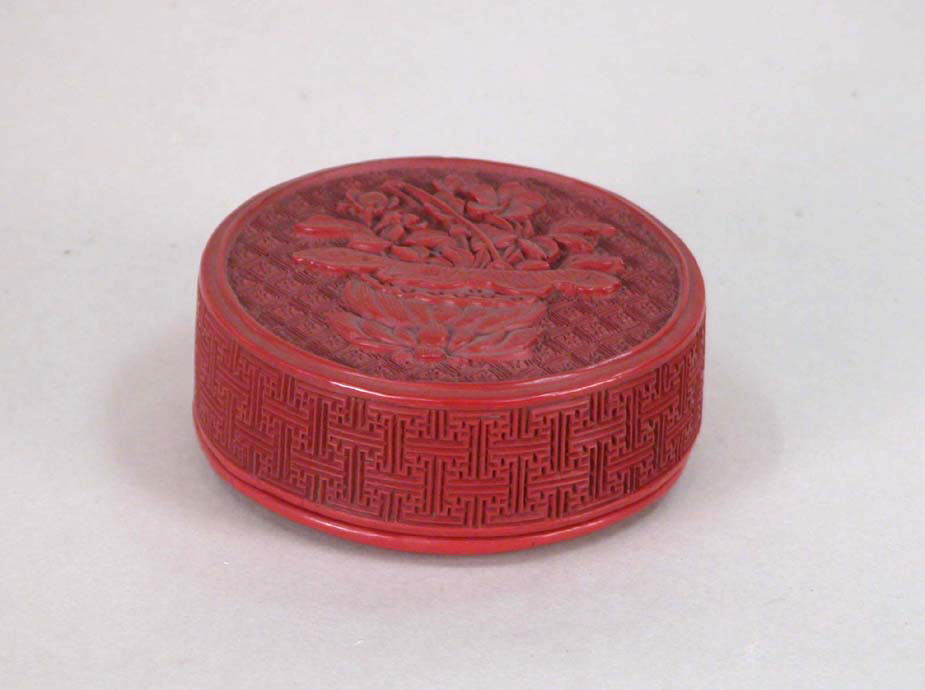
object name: box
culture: chinese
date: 1736-1795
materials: lacquer